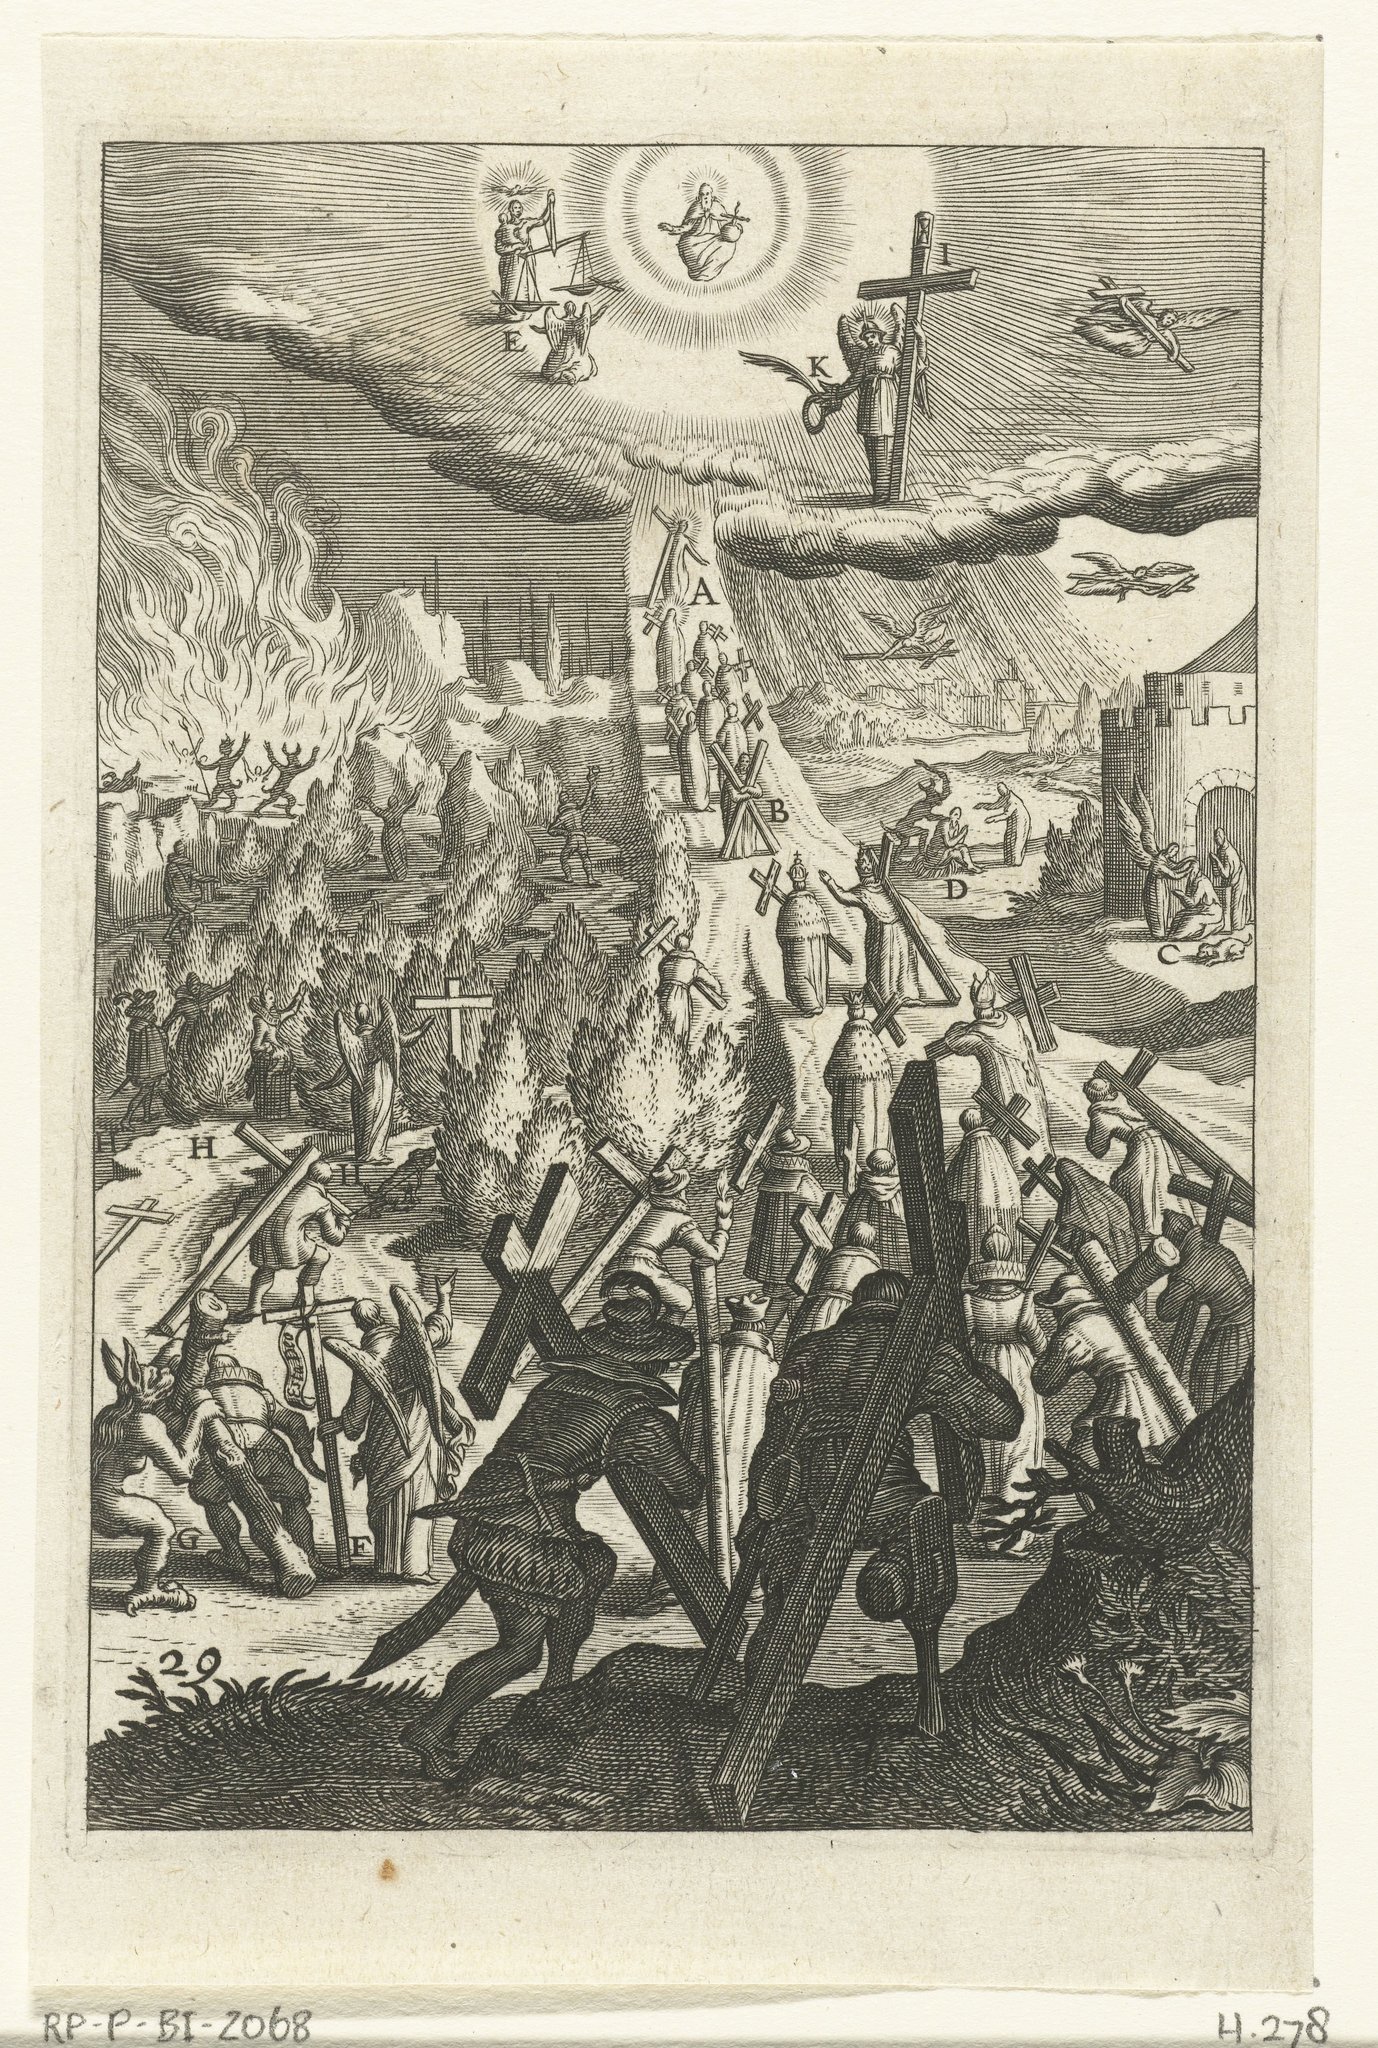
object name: book illustration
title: Embleem met de mens die zijn kruis draagt en zich bewust is van tegenslagen op zijn weg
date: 1620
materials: paper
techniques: engraving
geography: low countries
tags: the life of man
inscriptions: collector's mark: Lugt 2228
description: Prent uit: Antoine Sucquet, Den wech des eeuwich levens, beschreven int latijn : met beelden verlicht door Boëtius a Bolsvert, Antwerpen, Hendrick Aertssens, 1620, afb. tegenover p. 640